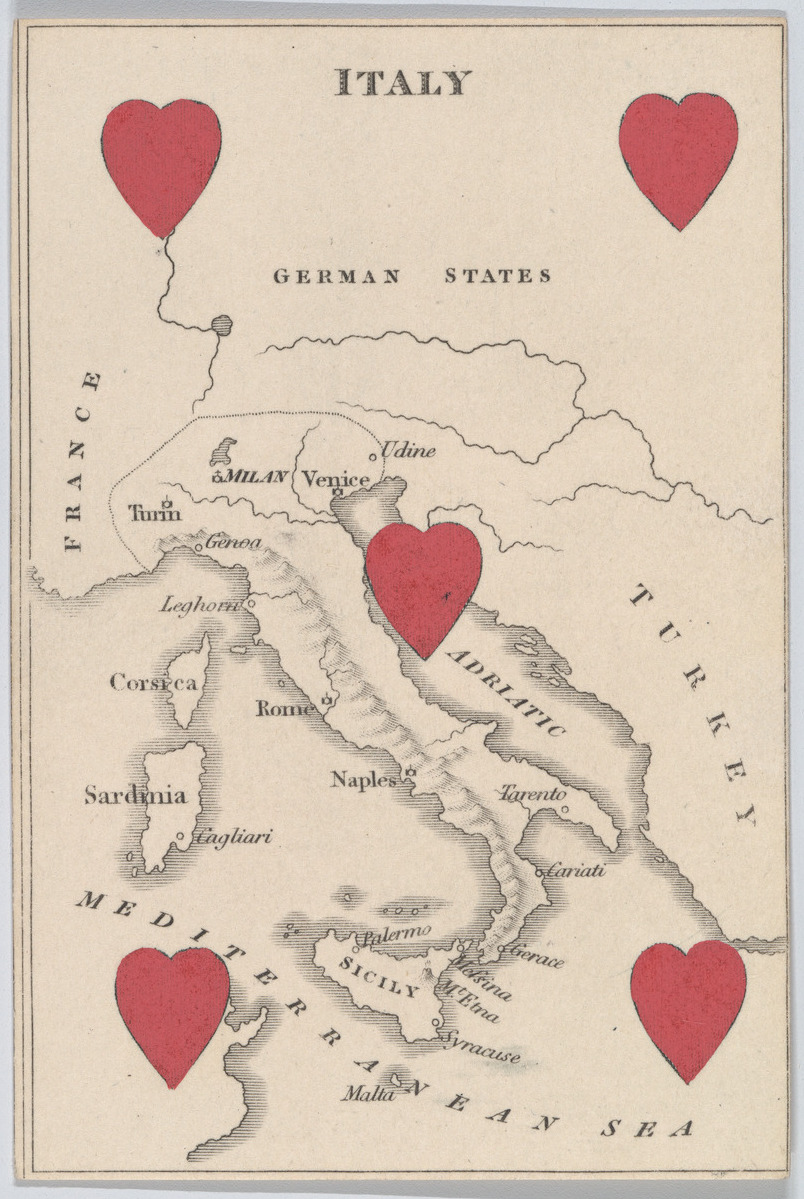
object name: print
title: Italy, from "Court Game of Geography"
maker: william and henry rock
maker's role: publisher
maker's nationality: british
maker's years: 1821-1884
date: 1838-1855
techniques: engraving, hand coloring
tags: playing cards,maps